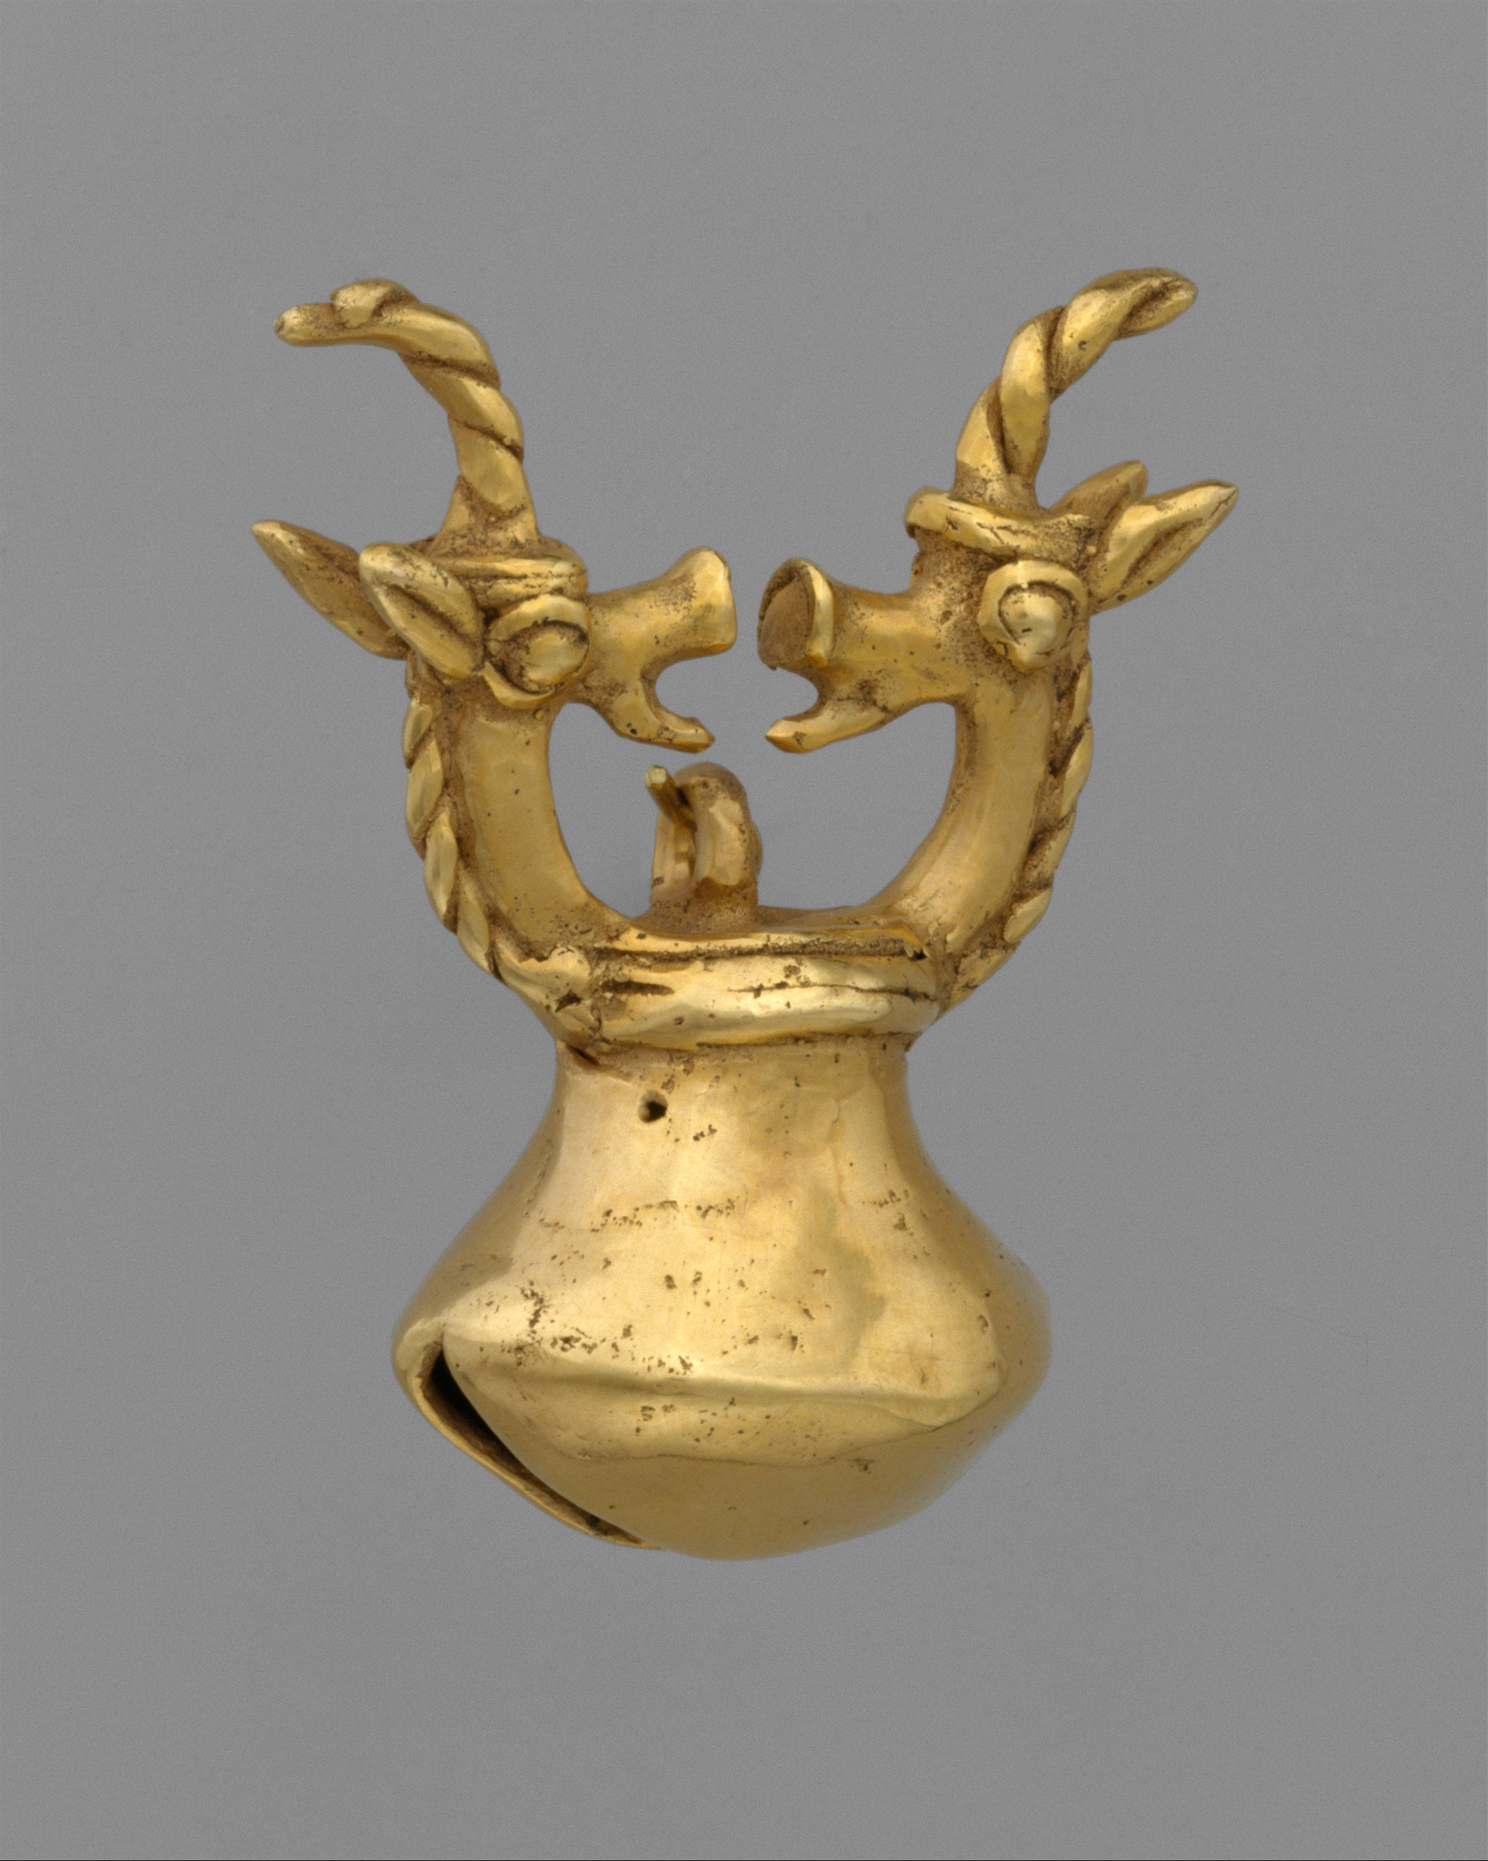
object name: bell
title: Deer-Head Bell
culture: chiriqui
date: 1001-1600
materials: gold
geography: costa rica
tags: musical instruments,deer